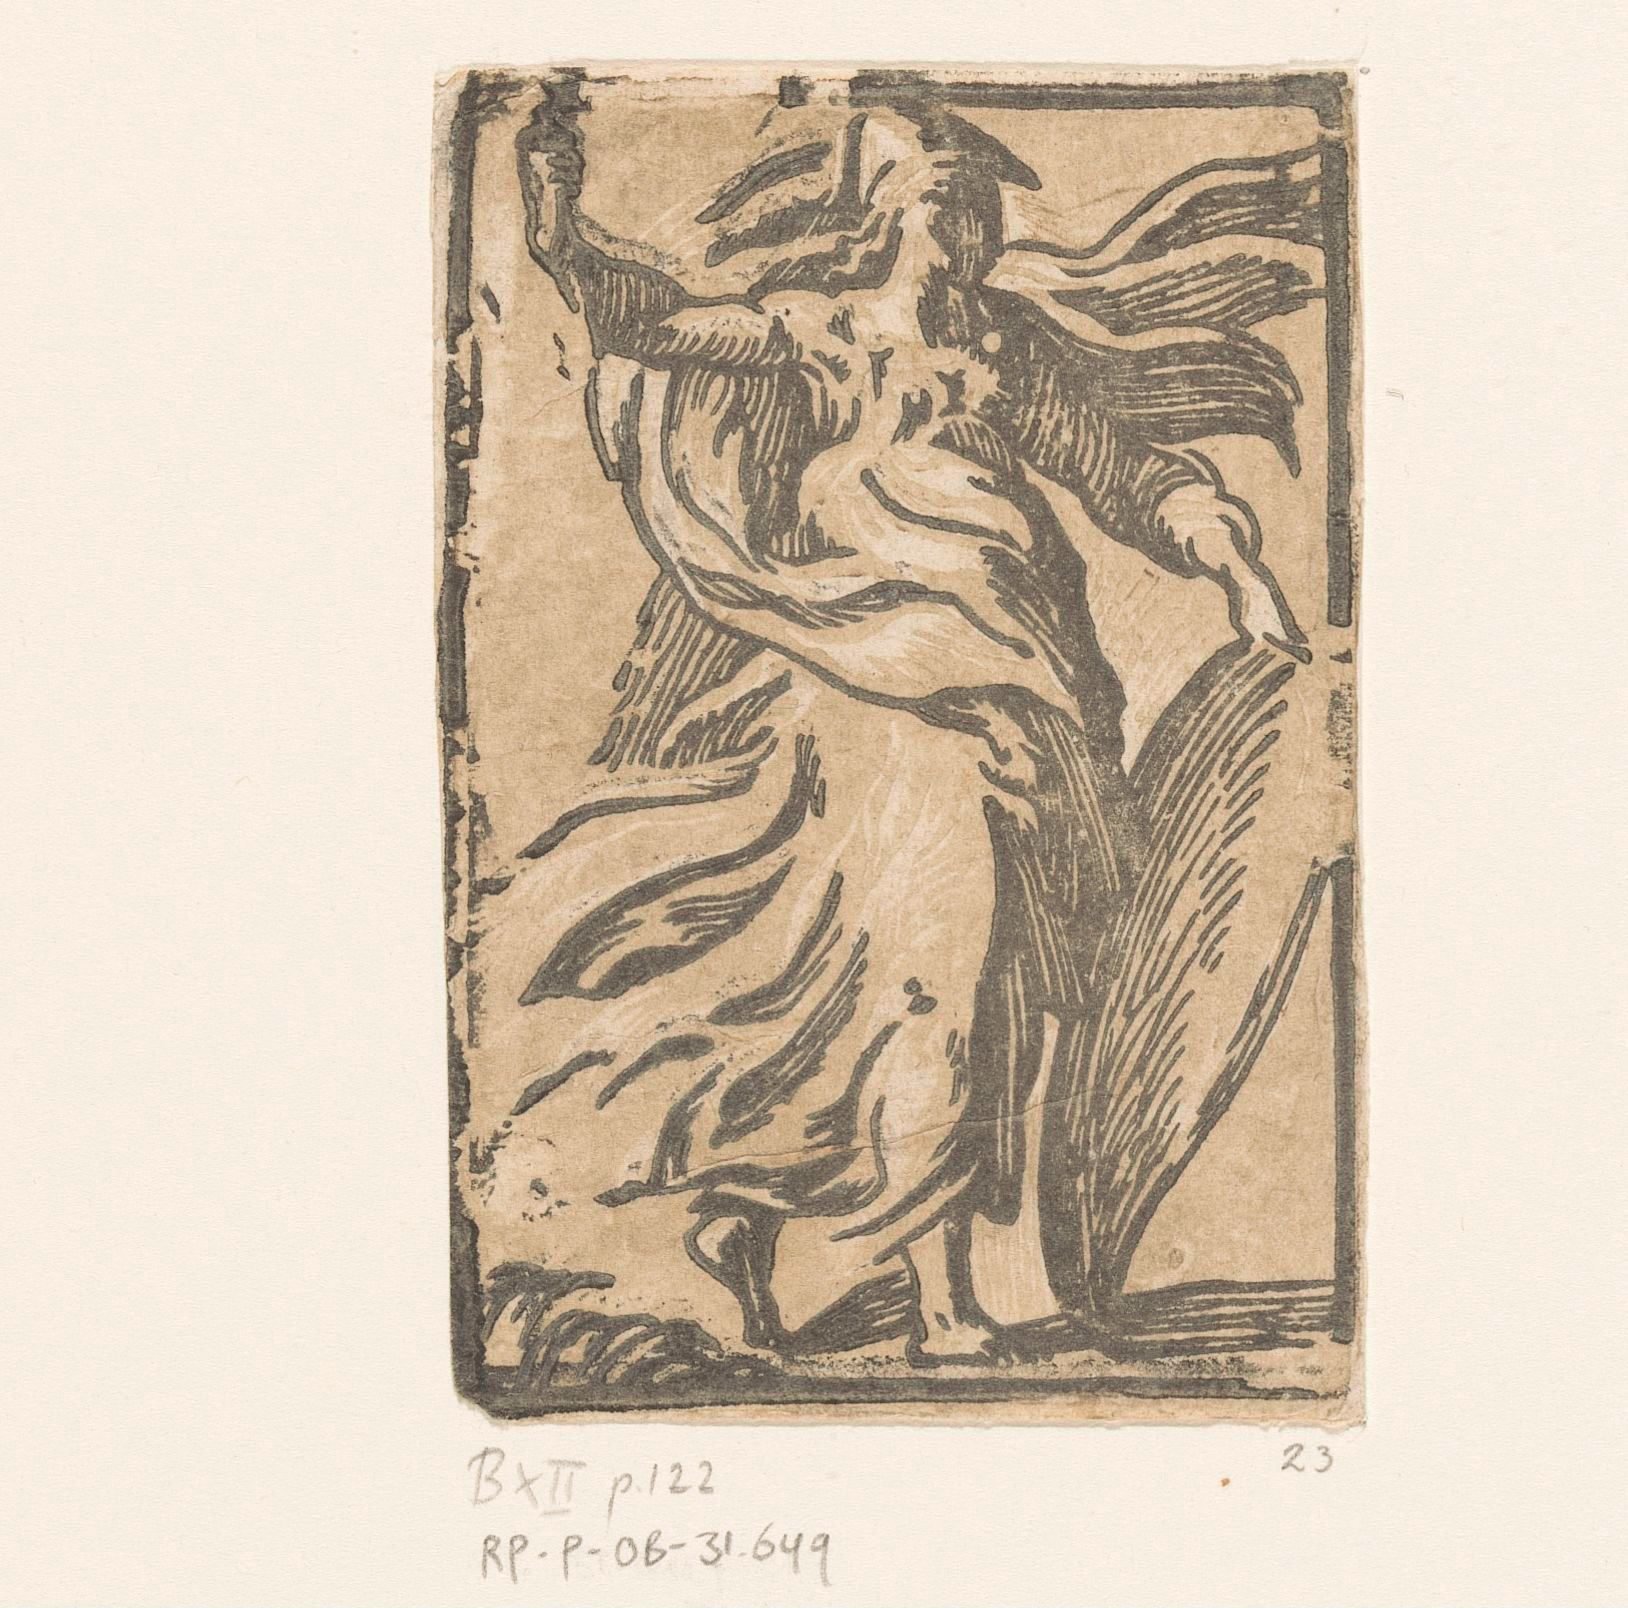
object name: print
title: Minerva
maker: antonio da trento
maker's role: painter, print maker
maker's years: 1510-1550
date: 1520-1550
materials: paper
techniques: woodcut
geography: italy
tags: (story of) minerva (pallas, athena)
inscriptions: collector's mark: Lugt 240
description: De staande Minerva, leunend op haar schild.